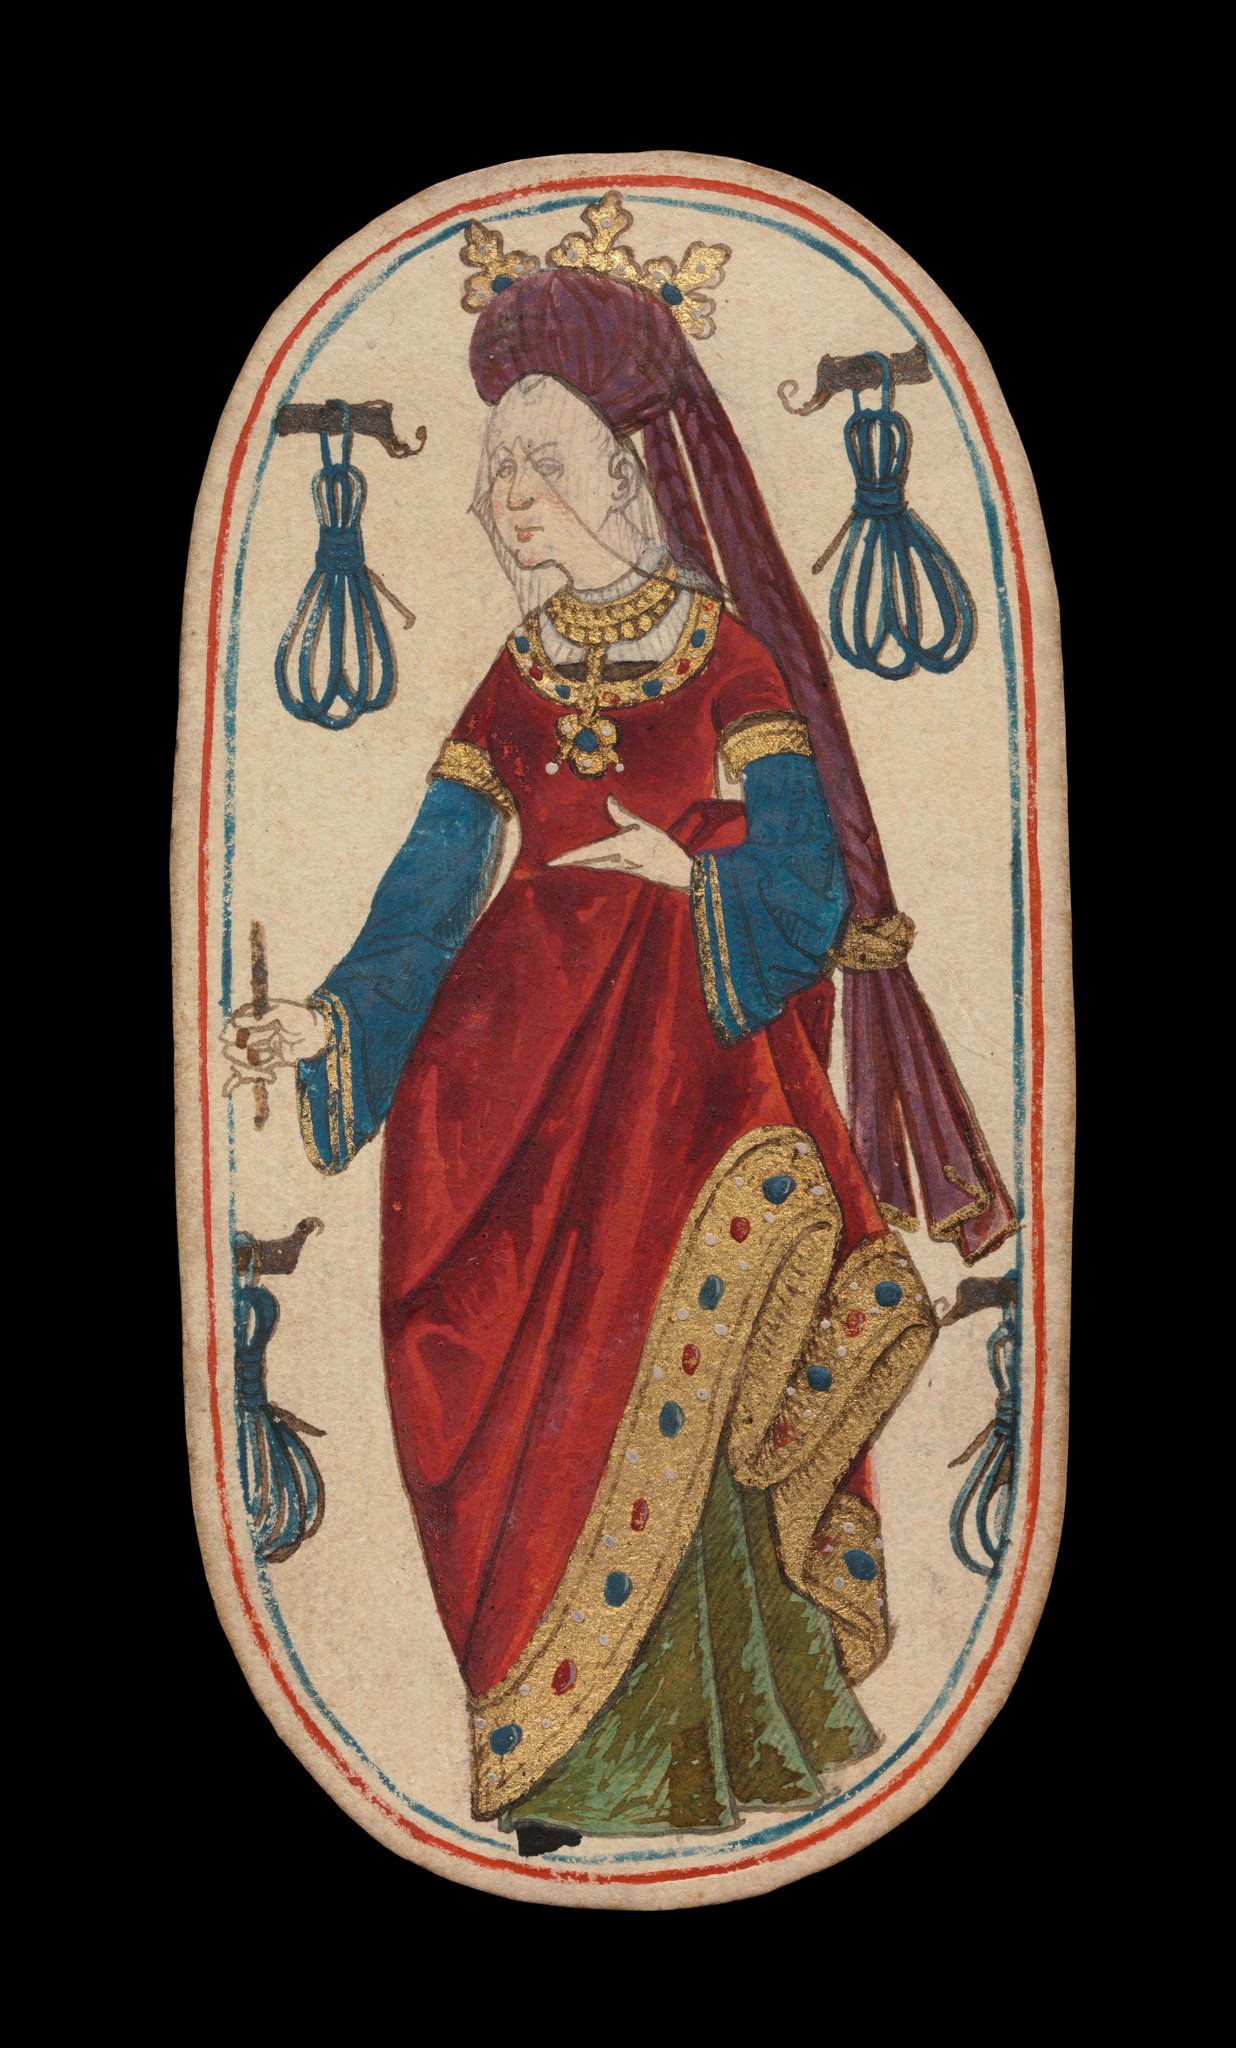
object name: playing card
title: Queen of Tethers, from The Cloisters Playing Cards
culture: south netherlandish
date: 1475-1480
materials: glaze, gold, ink, paint, paper, silver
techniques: pen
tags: queens,playing cards,games